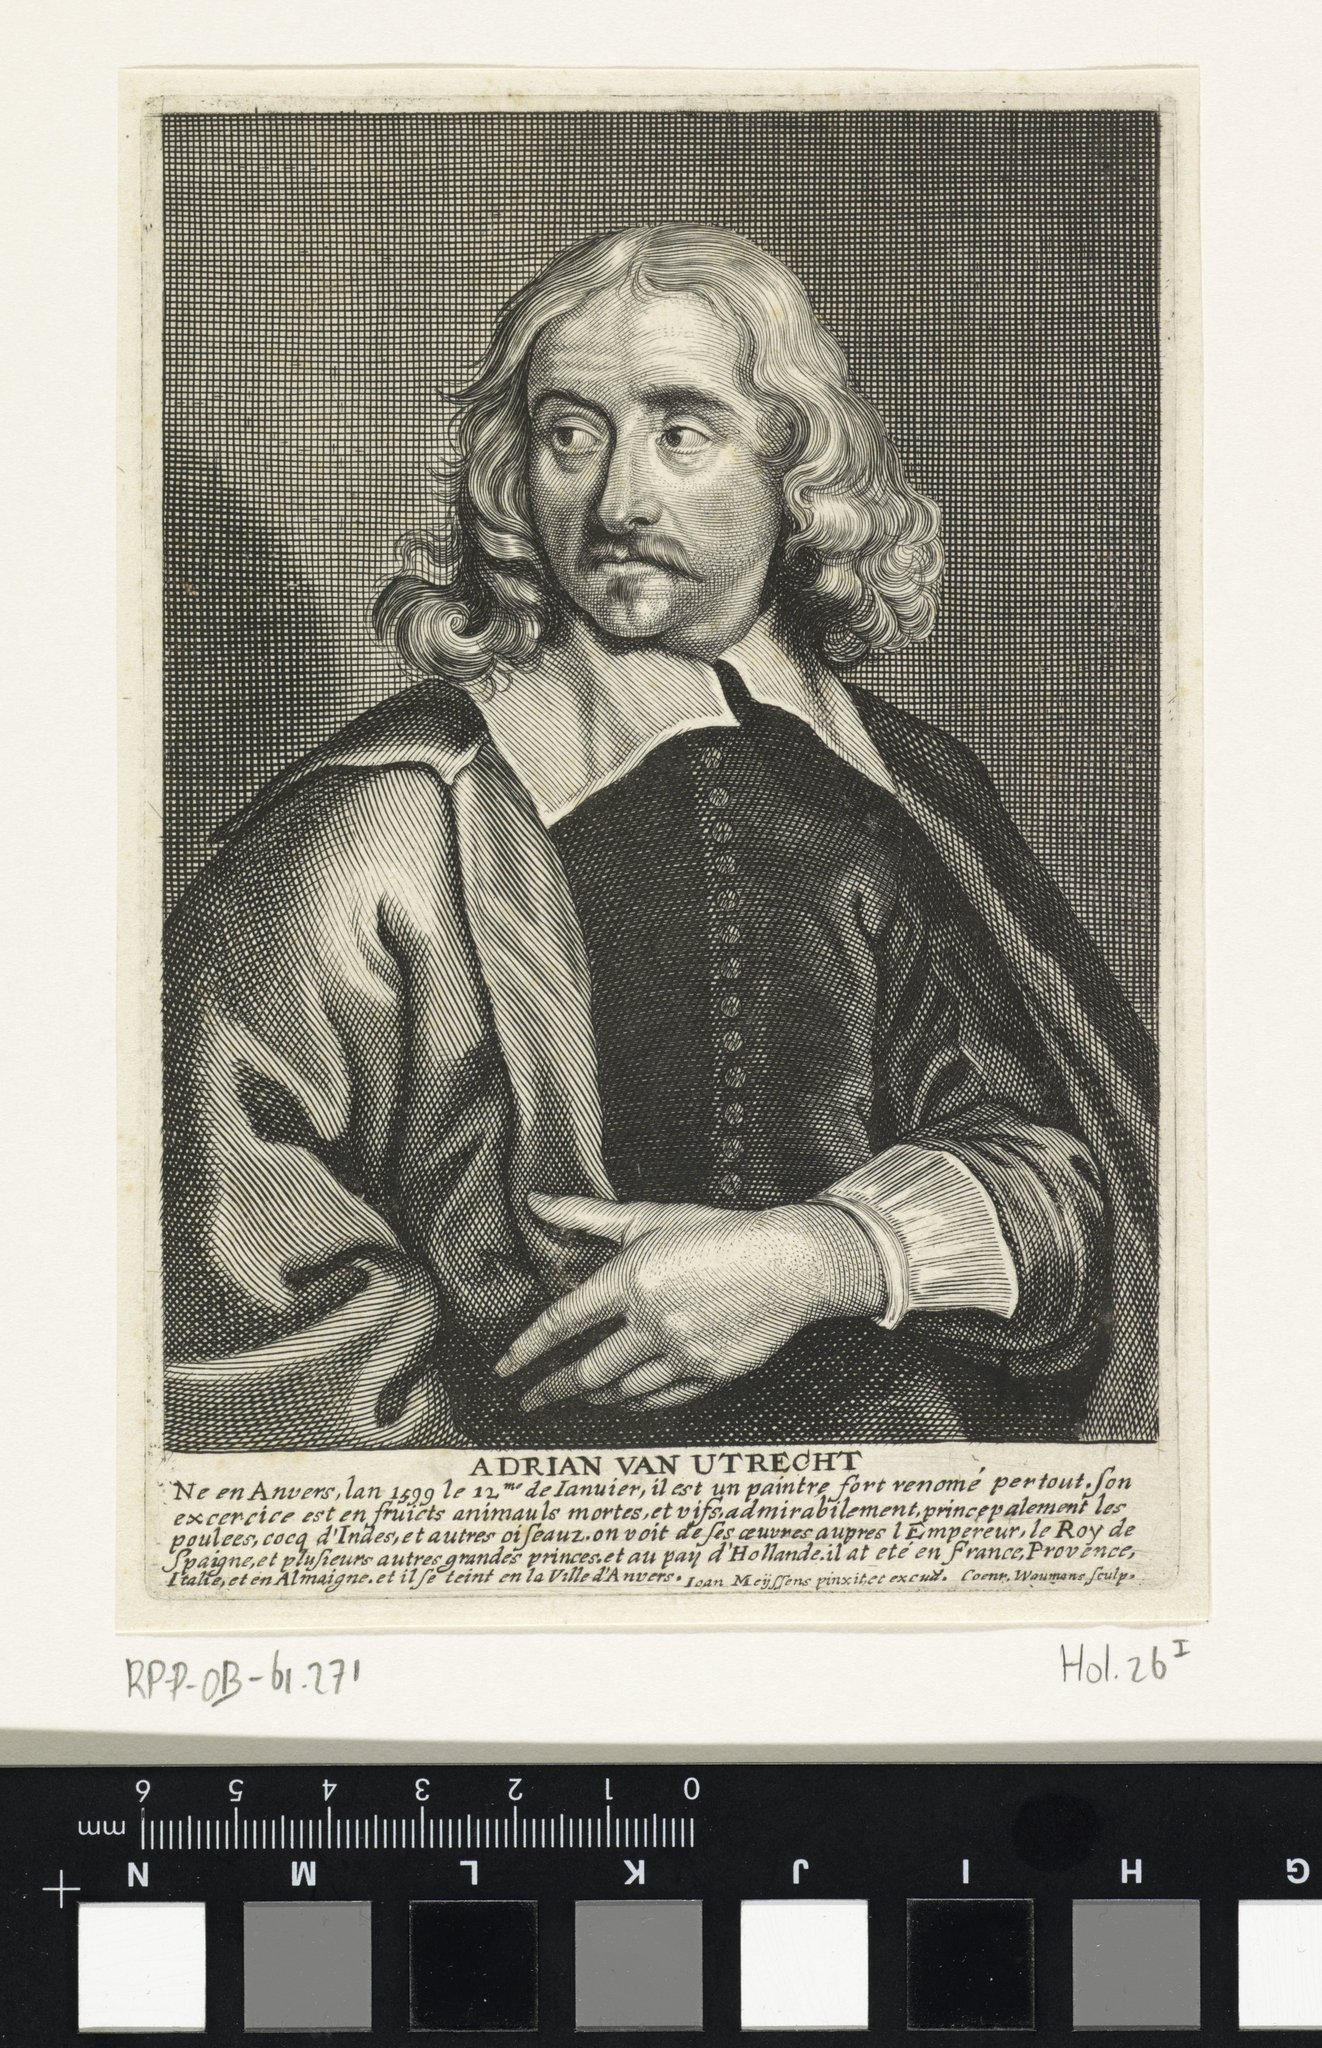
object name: print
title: Portret van de schilder Adriaen van Utrecht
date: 1649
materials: paper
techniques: engraving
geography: antwerp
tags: antwerp, painter, adriaen van utrecht, portrait, self-portrait of painter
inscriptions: collector's mark: Lugt 2228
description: Prent vermoedelijk uit: Meyssens, Joannes. Image de divers hommes desprit sublime qui par leur art et science deburovent vivre eternellement et des quels la louange et renommée faict estonner le monde. 2 dln. Antwerpen: Joannes Meyssens, 1649. Huidige staat (ongenummerd) van prent ook gebruikt in: Bie, Cornelis De. Het gulden Cabinet vande edel vry schilder const, inhoudende den lof vande vermarste schilders, architecte, beldthowers ende plaetsnyders van dese eeuw. Antwerpen: Joannes Meyssens, 1662 [1661 foutief op titelpagina]. Tweede bekende staat (genummerd 36) gebruikt in: Resta, Sebastiano. The true effigies of the most eminent painters and other famous artists that have flourished in Europe. Londen, 1694. Derde bekende staat (genummerd 16) gebruikt in: The Portraits of the Most Eminent Painters, and other Famous Artists (...). Londen: Olive Payne, 1739.